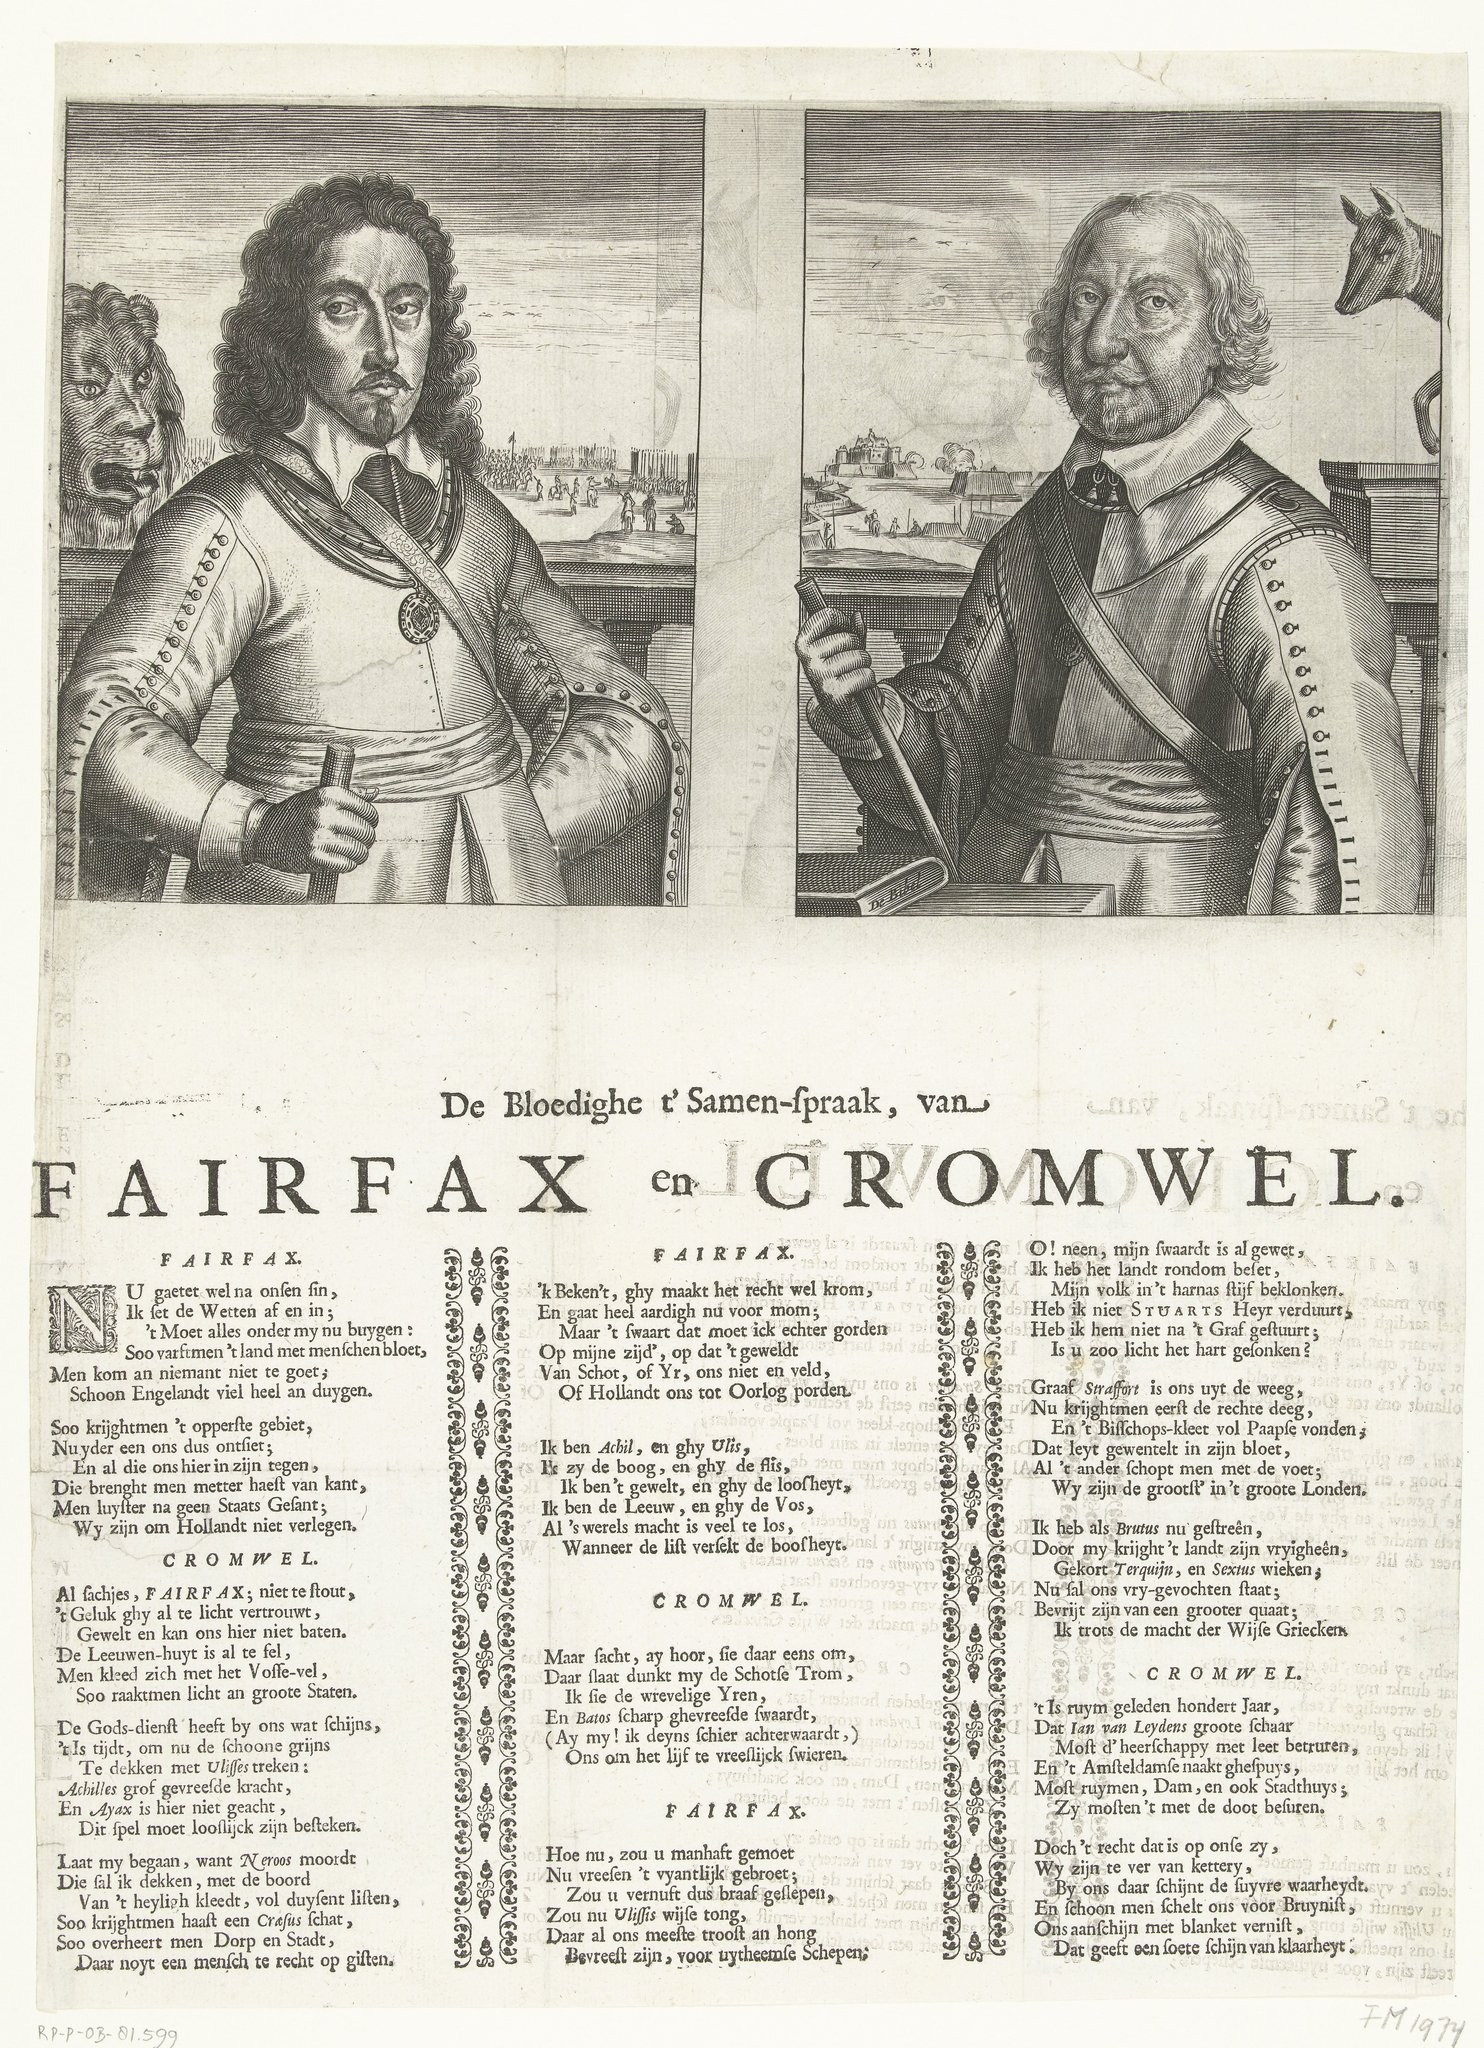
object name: cartoon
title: De Bloedighe t'Samen-spraak, van Fairfax en Cromwel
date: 1649-1650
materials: paper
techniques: engraving, letterpress printing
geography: northern netherlands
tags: karel i (koning van engeland), london, oliver cromwell, on the scaffold or place of execution, violent death by beheading, lying in state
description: Blad met de portretten van Thomas Fairfax en Oliver Cromwell. Onder de plaat is op het blad gedrukt een samenspraak in 3 kolommen in het Nederlands tussen Fairfax en Cromwell over de toestand in Engeland na de gevangenneming en de onthoofding van de Engelse koning Karel I te Londen op 30 januari 1649. Achter Fairfax een leeuwenkop, achter Cromwell een vos.